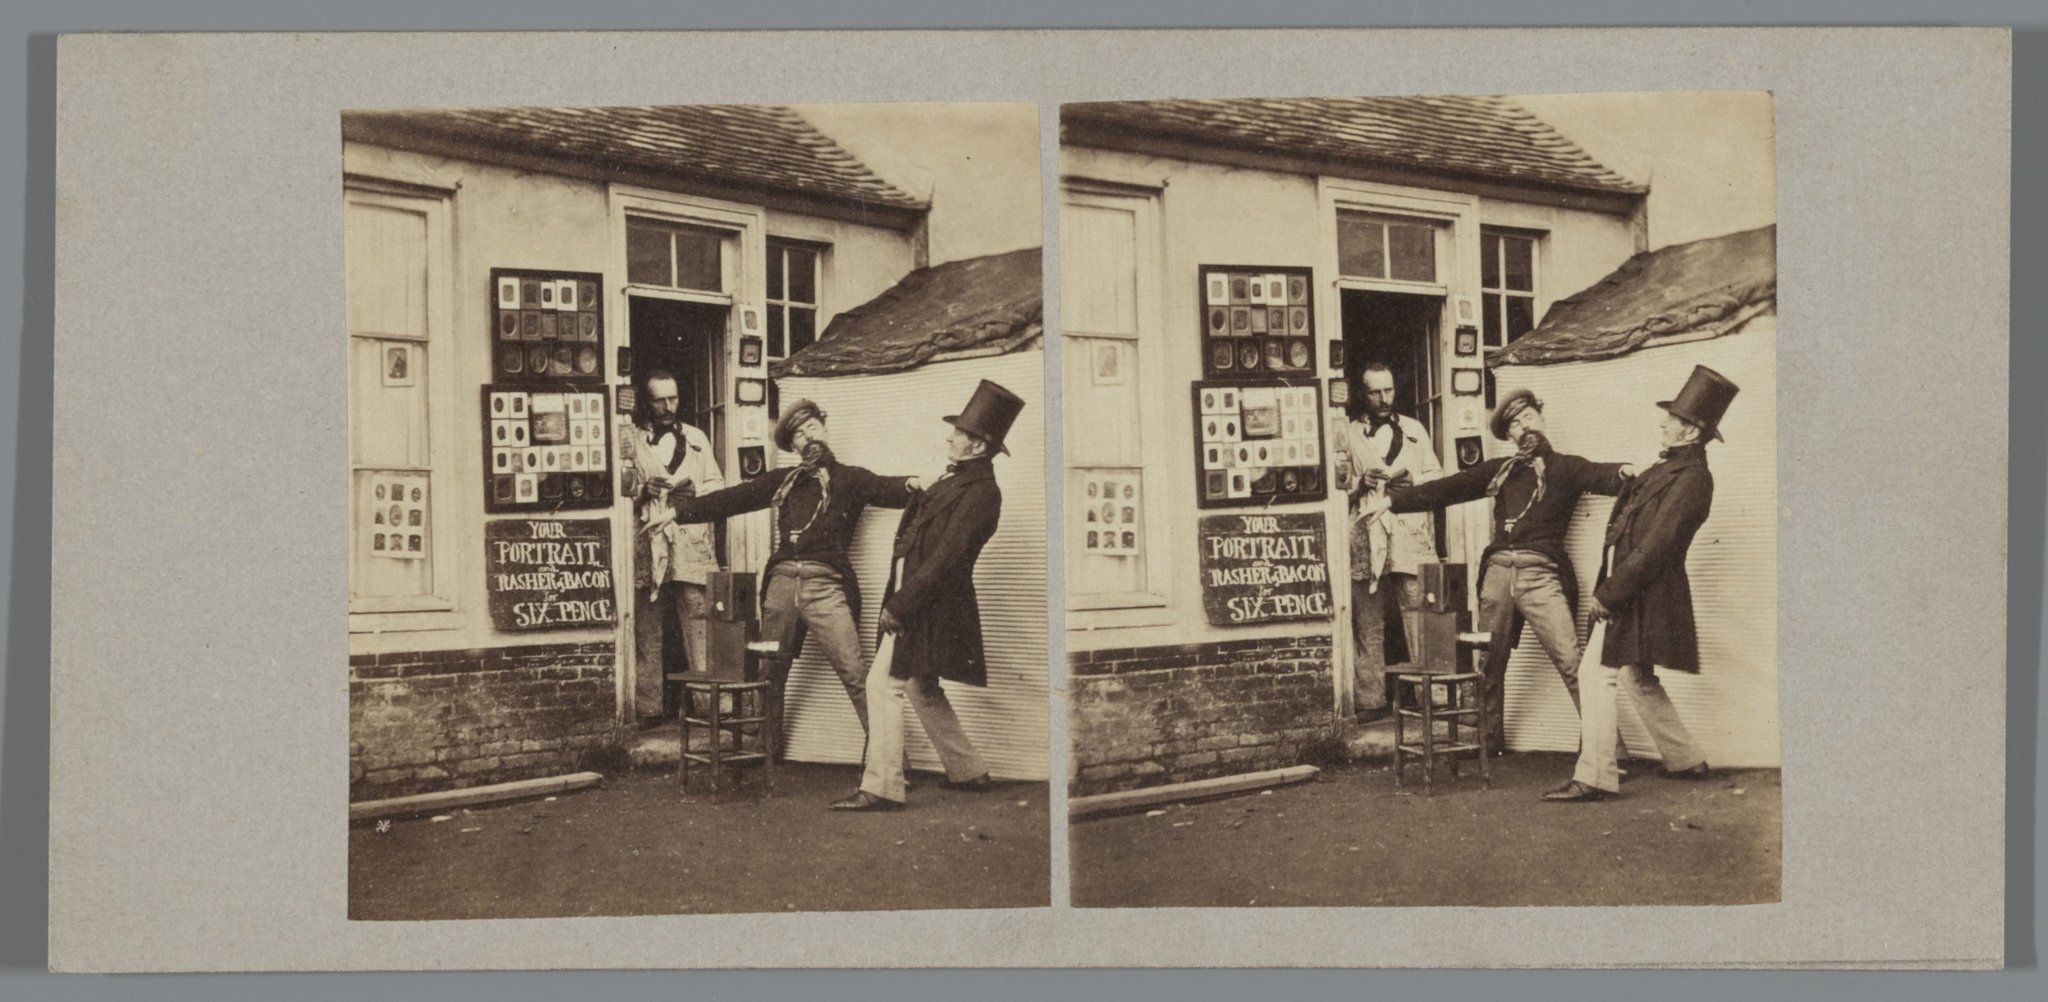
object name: stereograph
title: Fotoatelier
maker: Anonymous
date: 1860-1870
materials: cardboard, photographic support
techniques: albumen print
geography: england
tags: great britain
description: Genrescène met fotoatelier, waarbij een 'doorman' een klant naar binnen probeert te lokken.